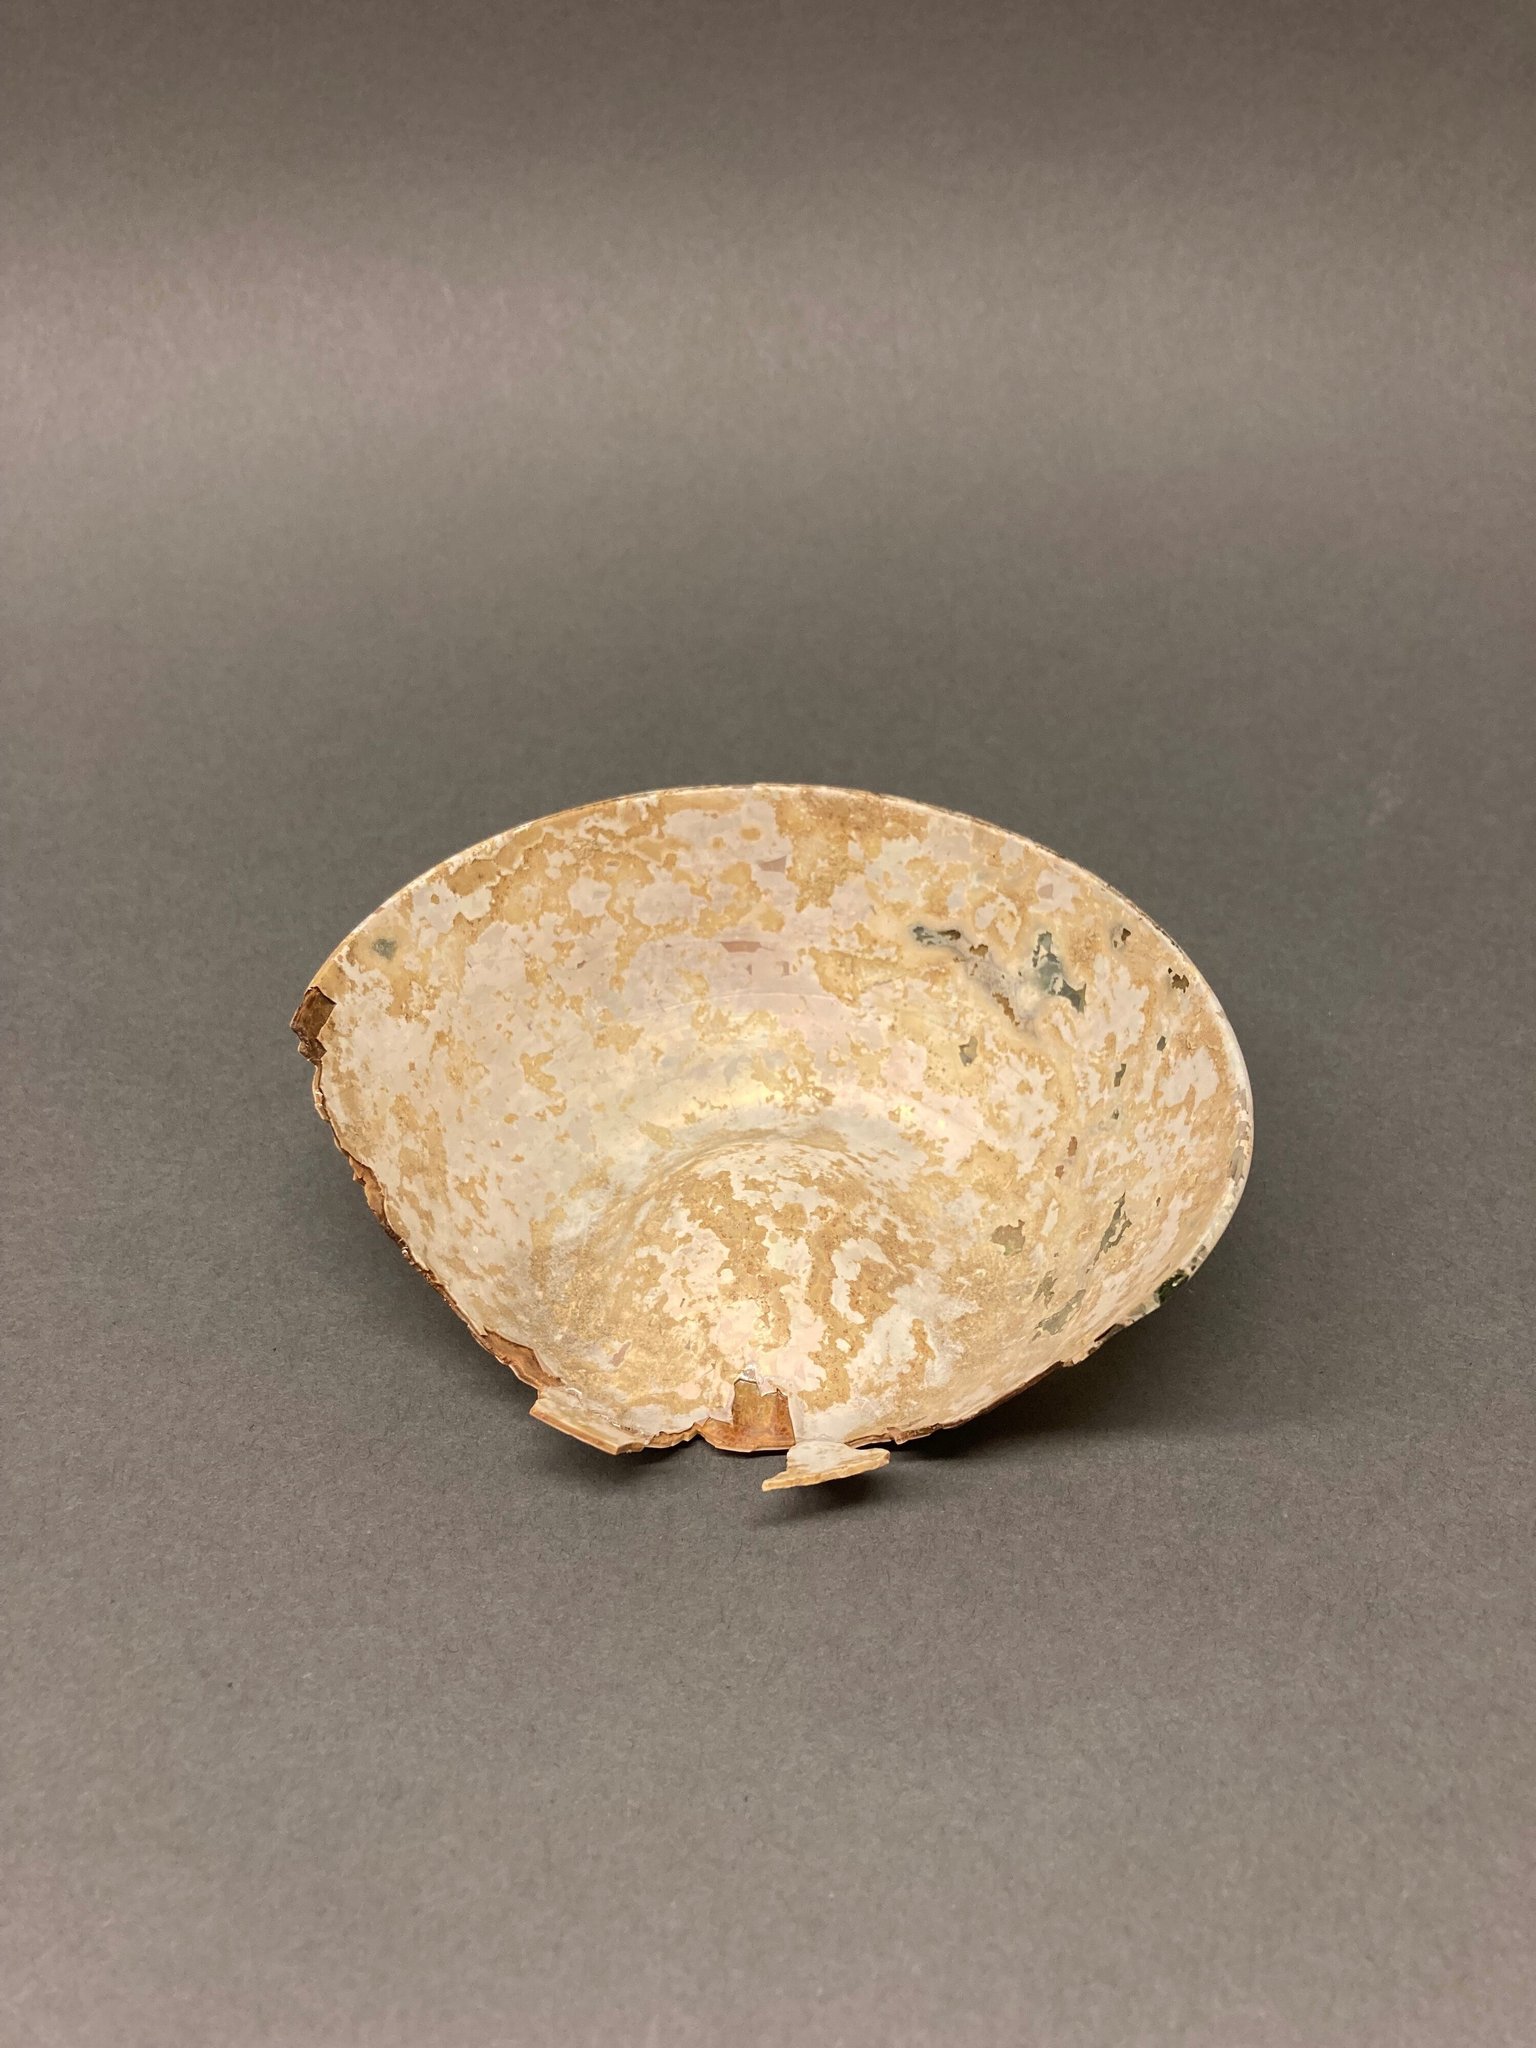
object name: fragment of a bowl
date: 901-1100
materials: glass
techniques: glassblowing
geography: iran